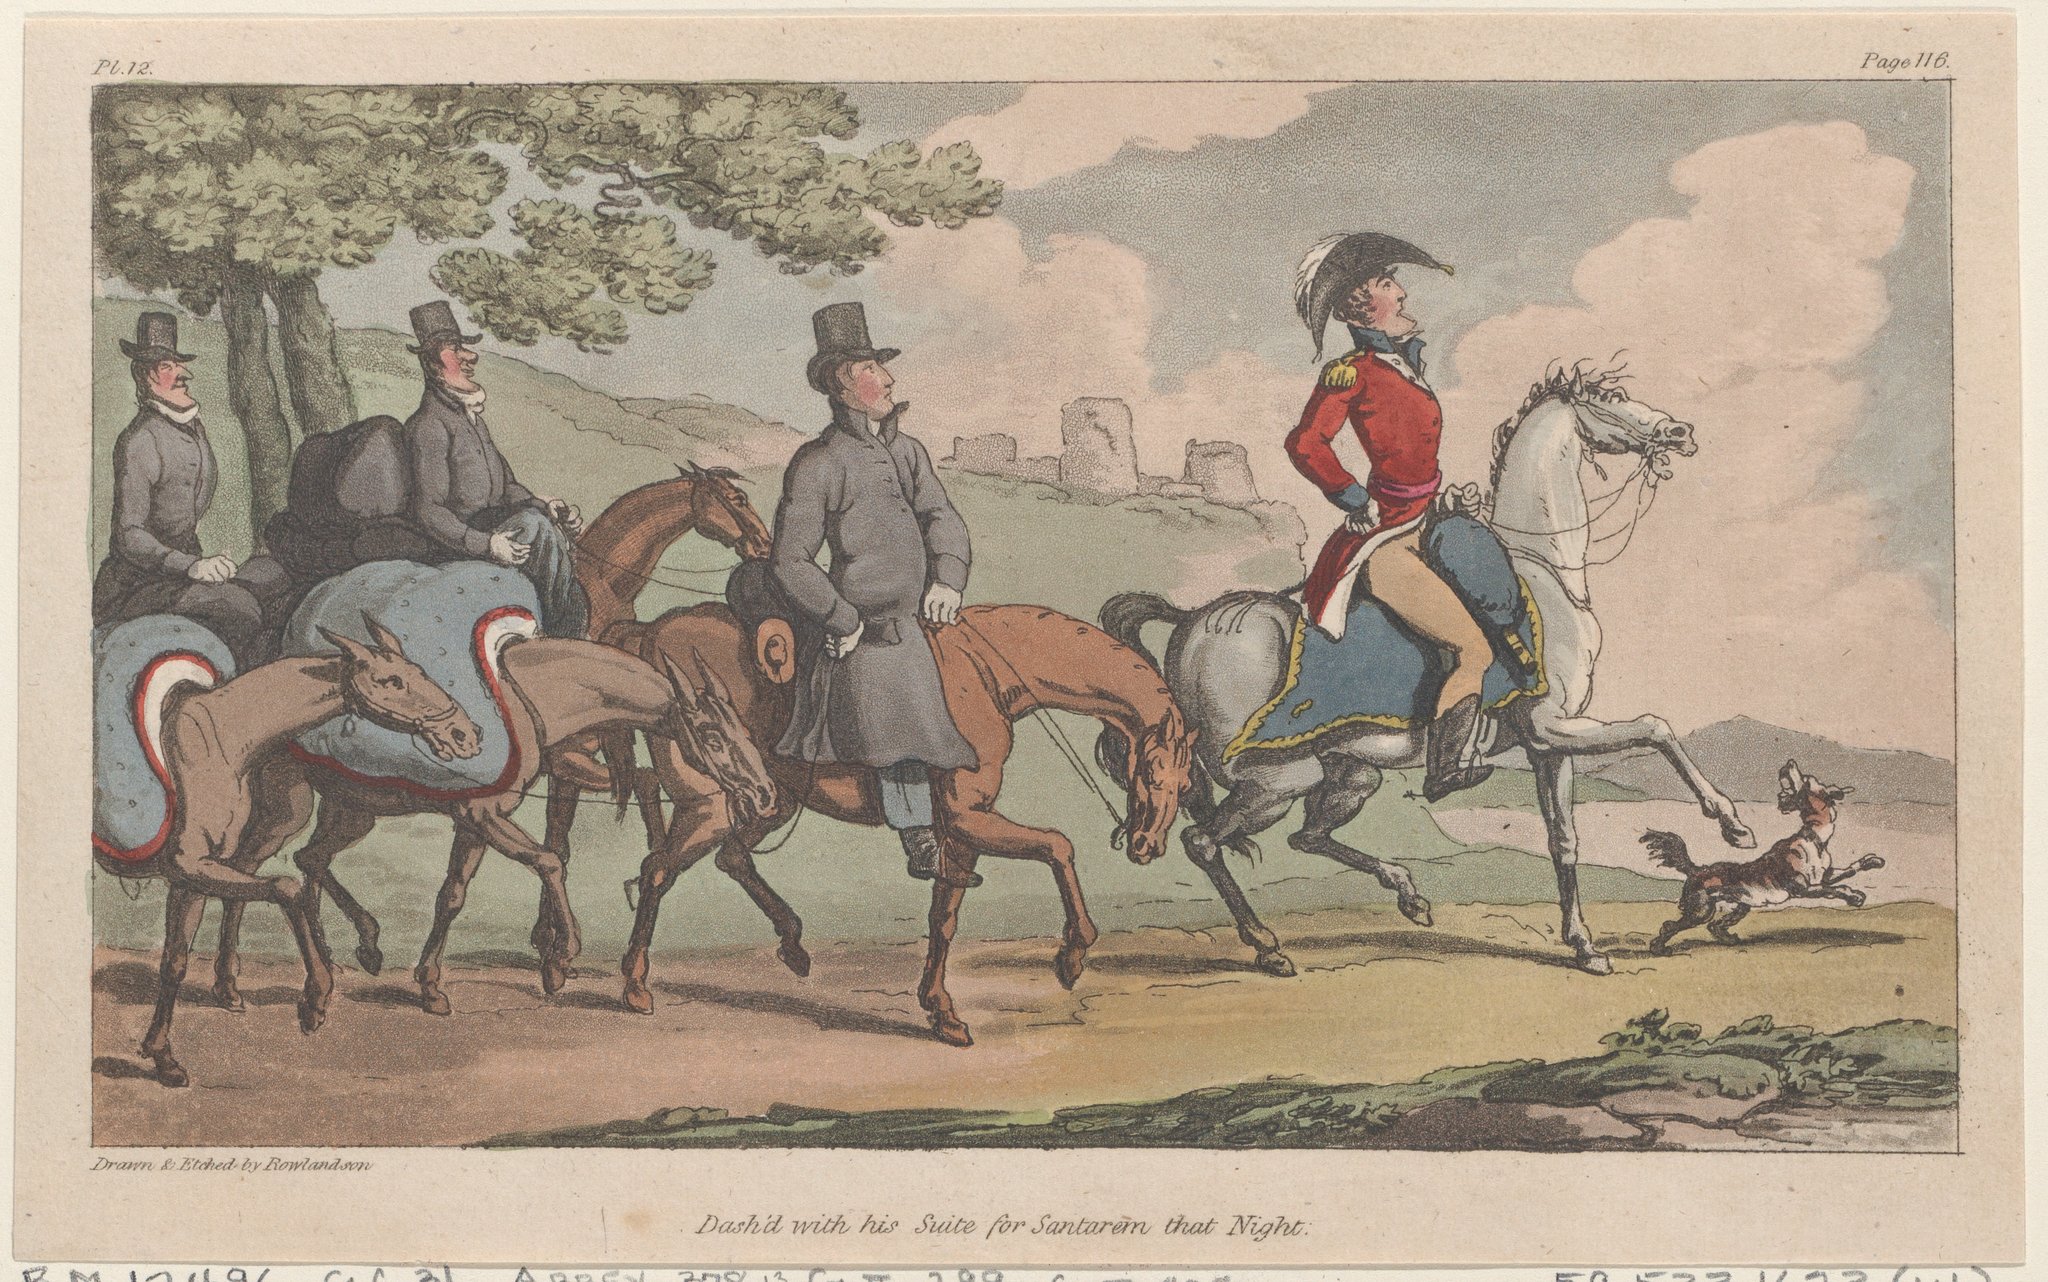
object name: print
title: Dash'd with his suite for Santarem that night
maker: thomas rowlandson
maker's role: artist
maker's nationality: british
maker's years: 1757-1827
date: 1815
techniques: aquatint, etching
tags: men,dogs,horses